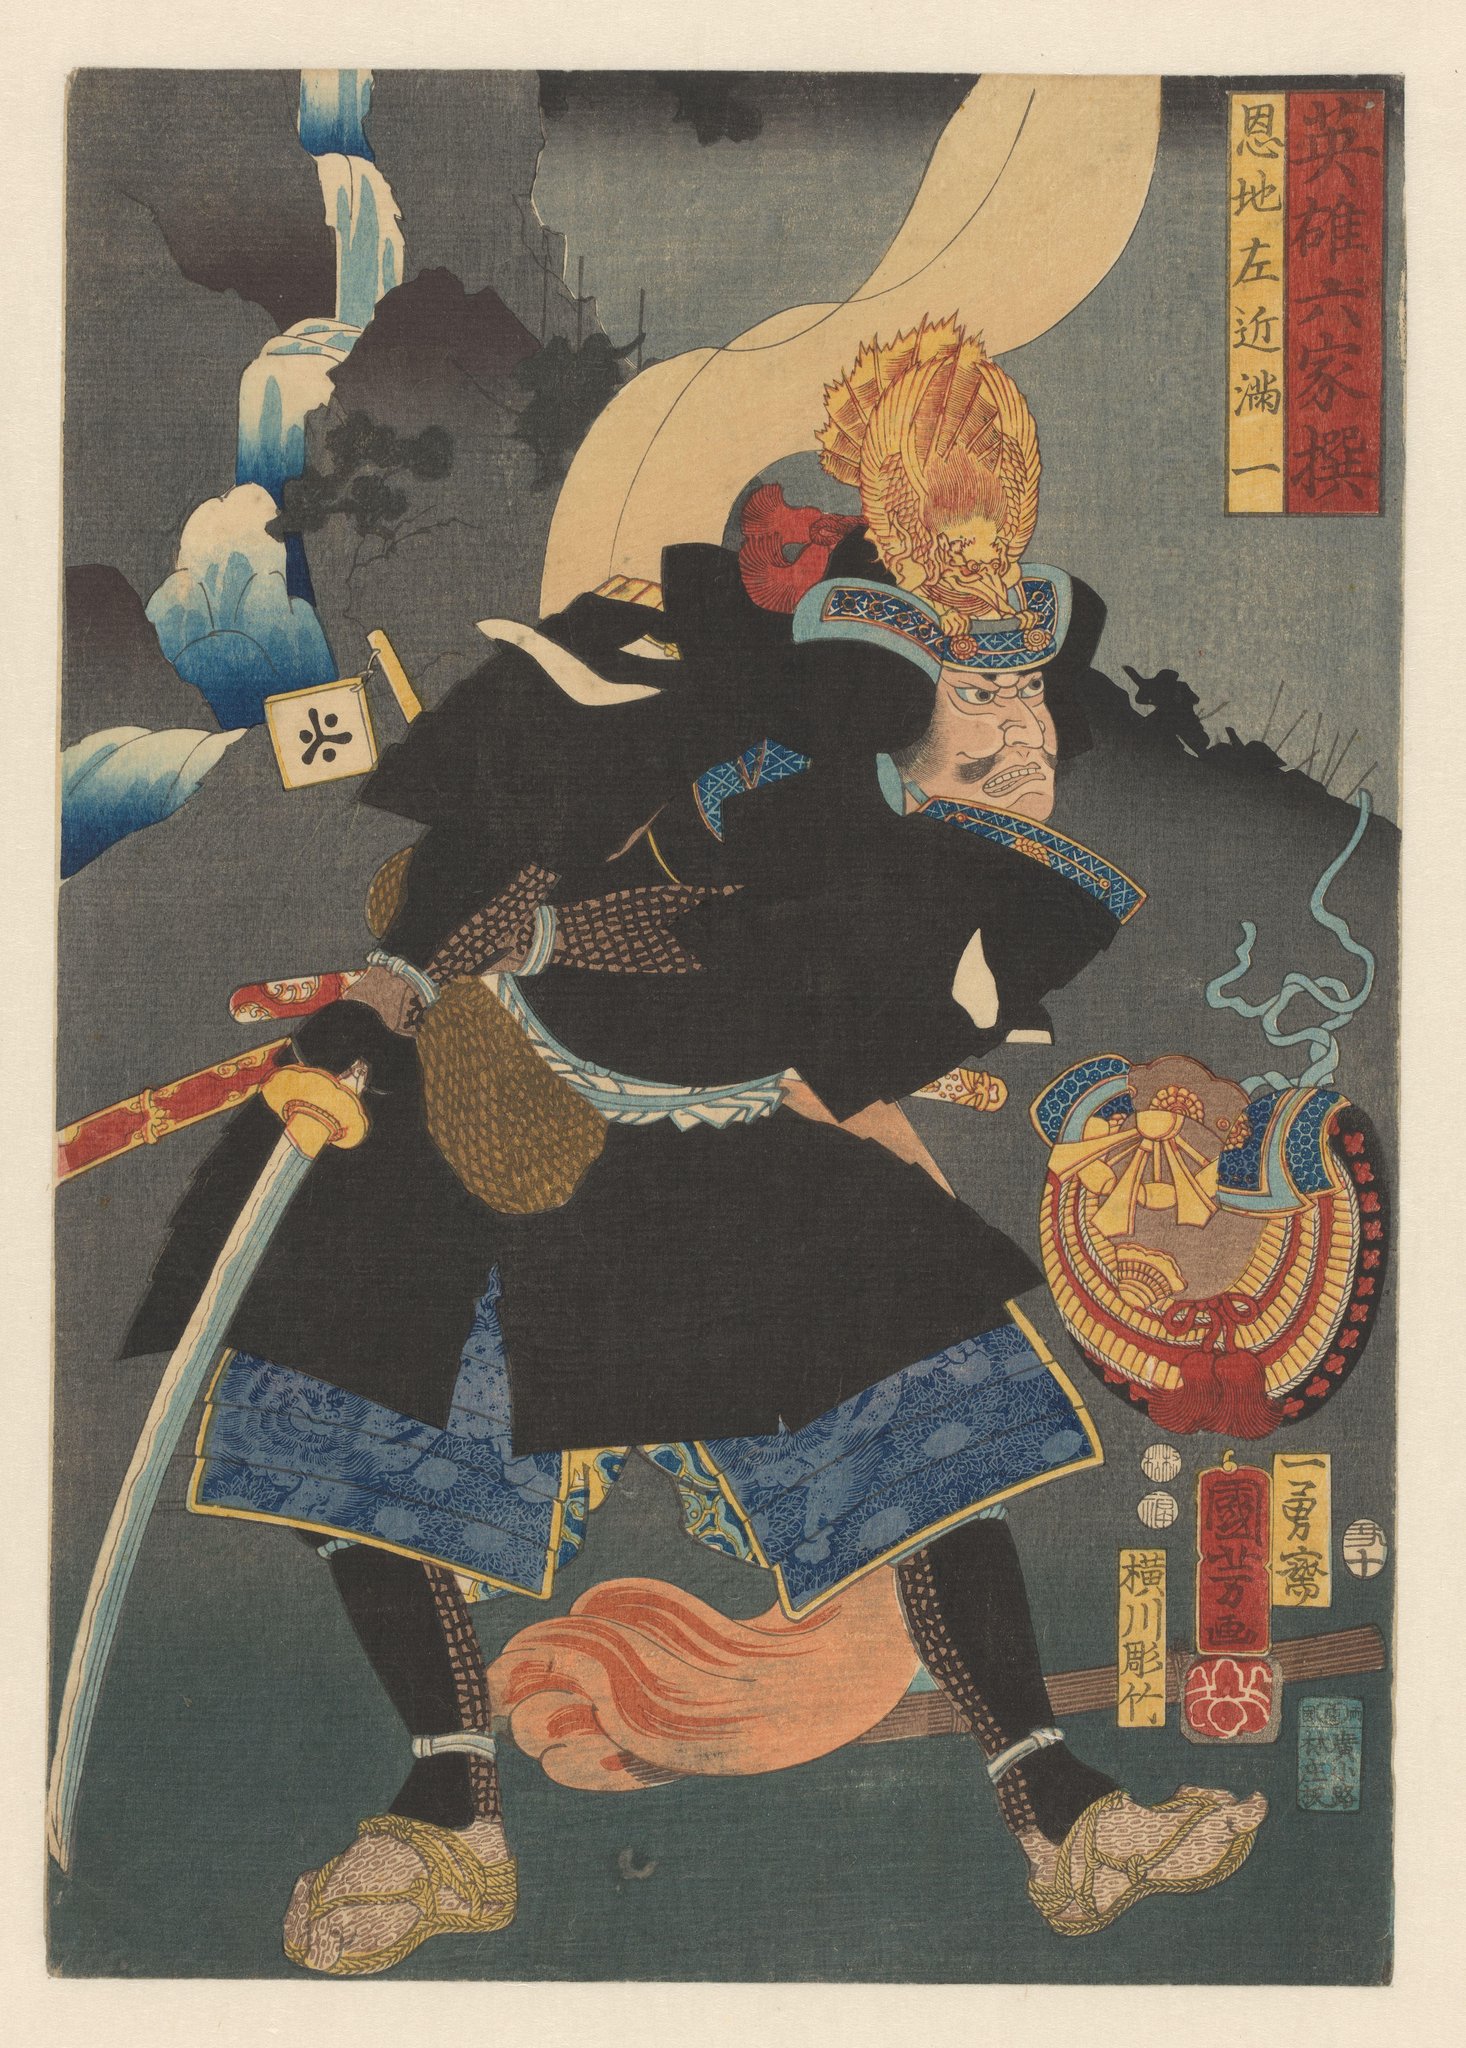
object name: print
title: Six selected heroes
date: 1801-1865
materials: paper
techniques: woodcut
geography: japan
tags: armour, waterfall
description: Onchi Sakon Mitsukazu in zwart krijgerstenue, gouden helm en zwaard in zijn hand tijdens een gevecht in de bergen. Naast hem een afgevallen helm, op de achtergrond een waterval.